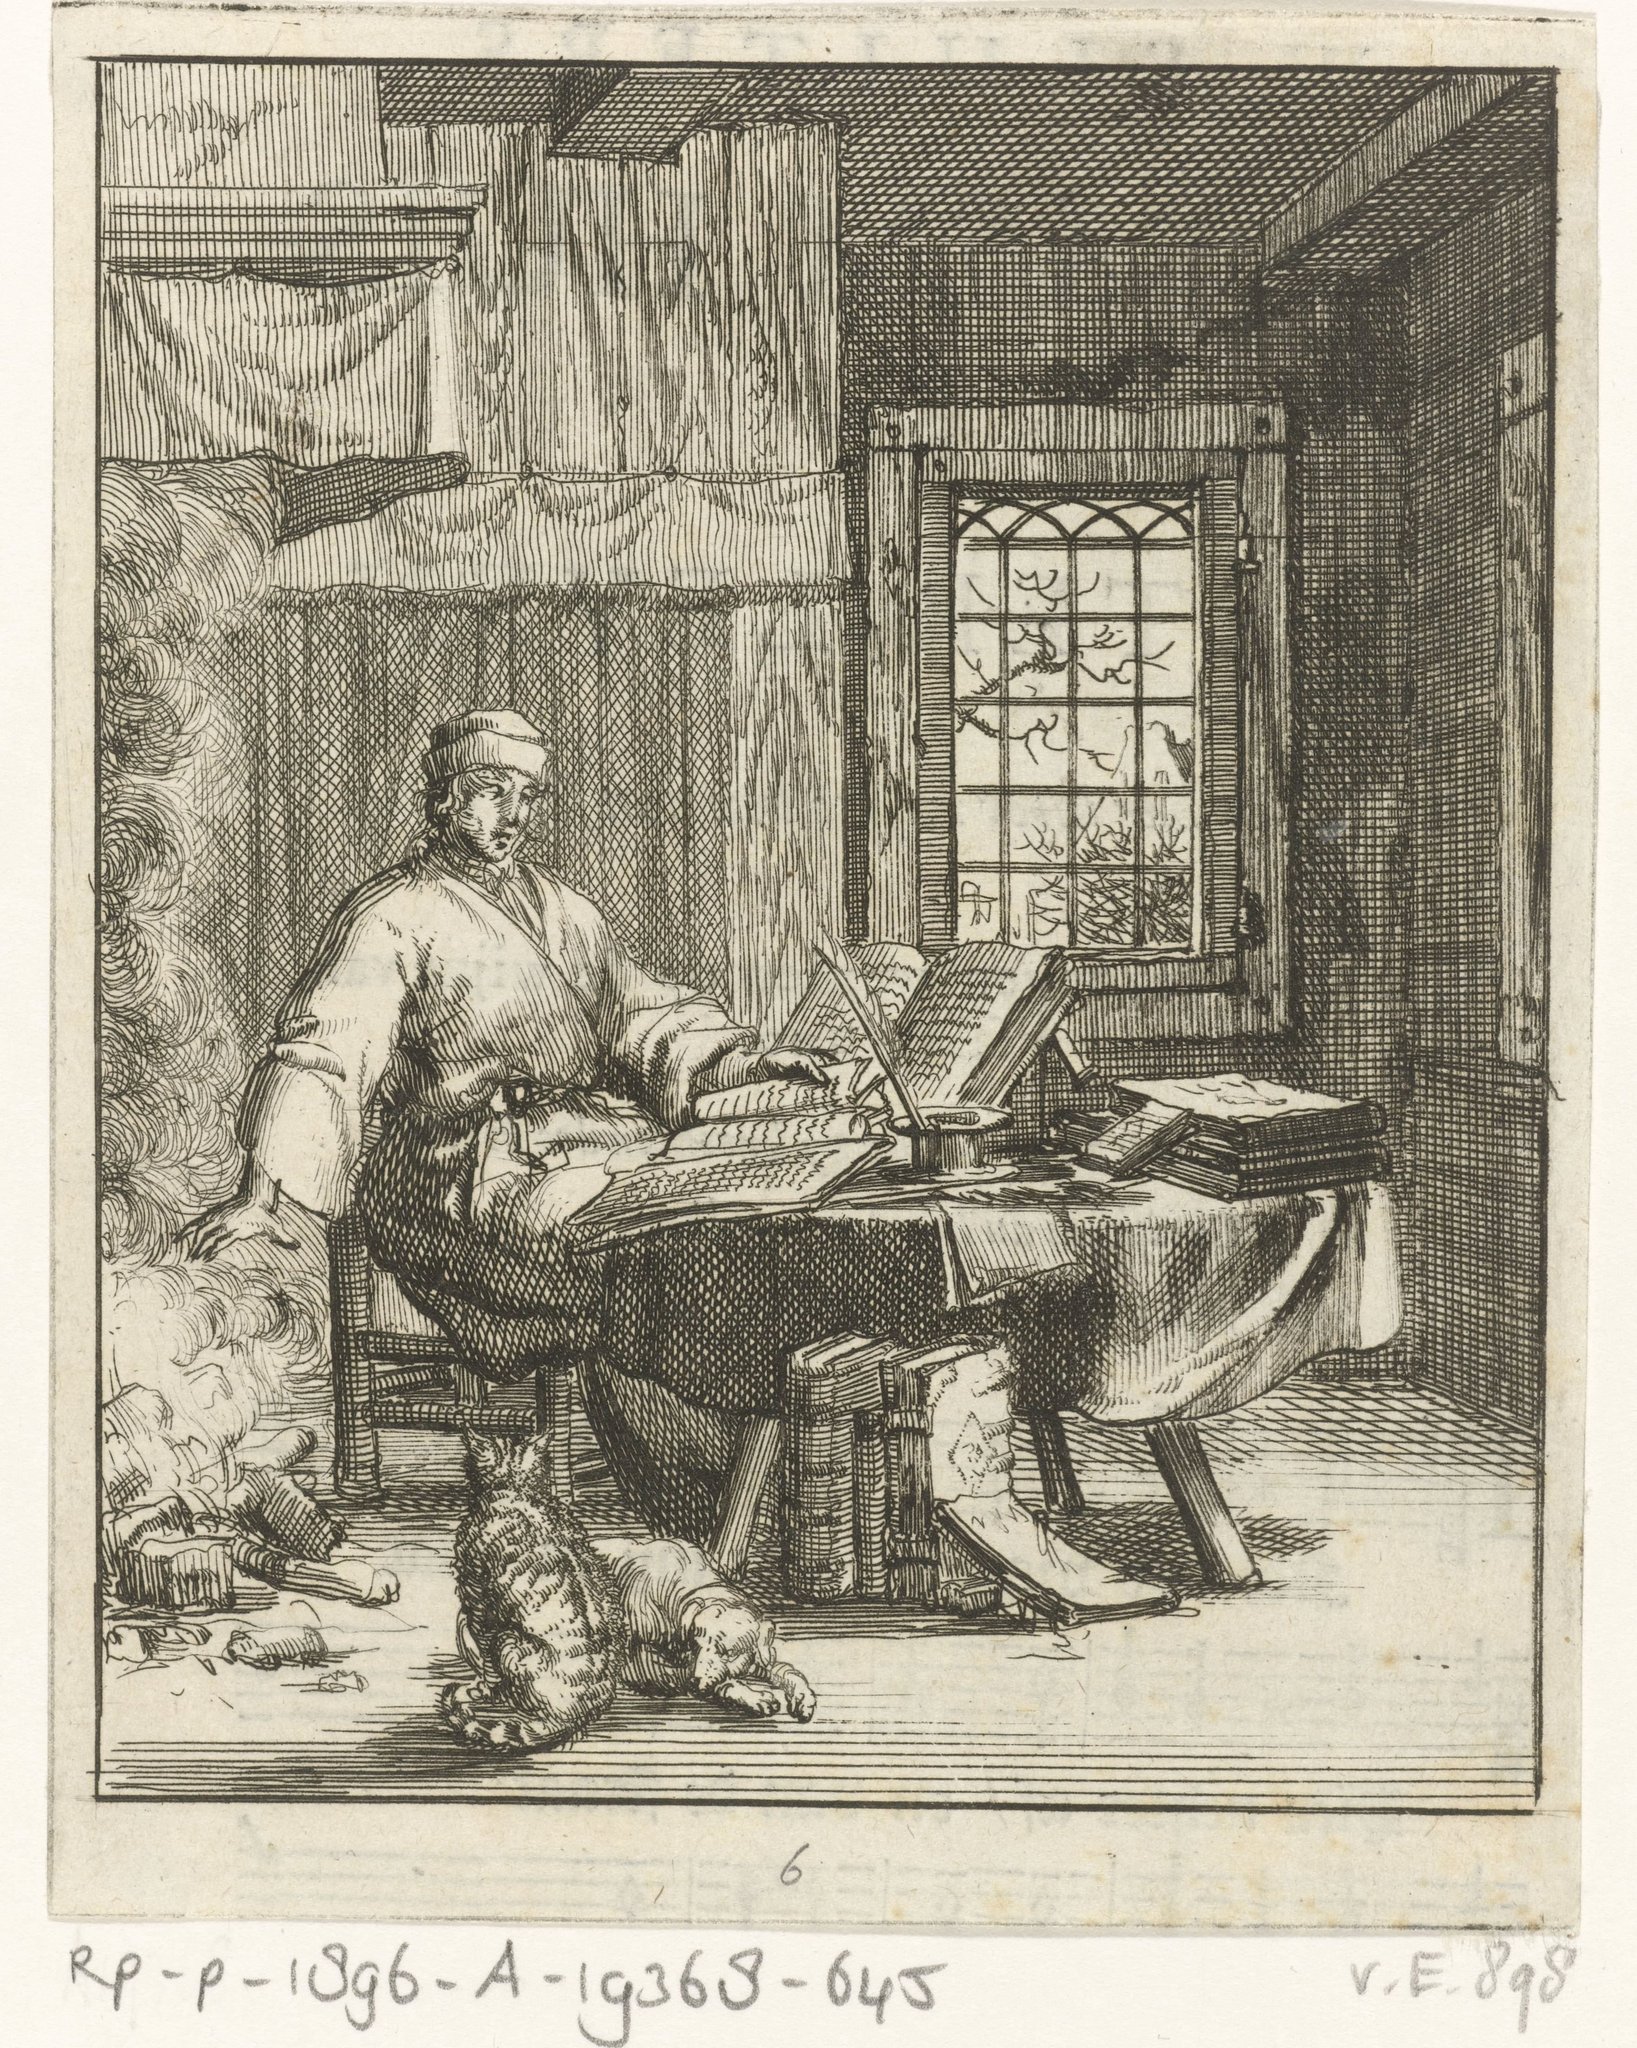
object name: print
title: Schrijver Willem Sluiter zit met folianten aan tafel en warmt zijn handen aan het vuur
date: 1687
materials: paper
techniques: etching, letterpress printing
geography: amsterdam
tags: writing-table, writing-desk, open fire, fire-place, stove (in kitchen)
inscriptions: collector's mark: Lugt 2228, number: ‘6’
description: Illustratie uit: Sluiter, Willem. Buiten- eensaem huis- somer- en winter-leven. Amsterdam: Gerbrandt Schagen, 1687, p. 8.